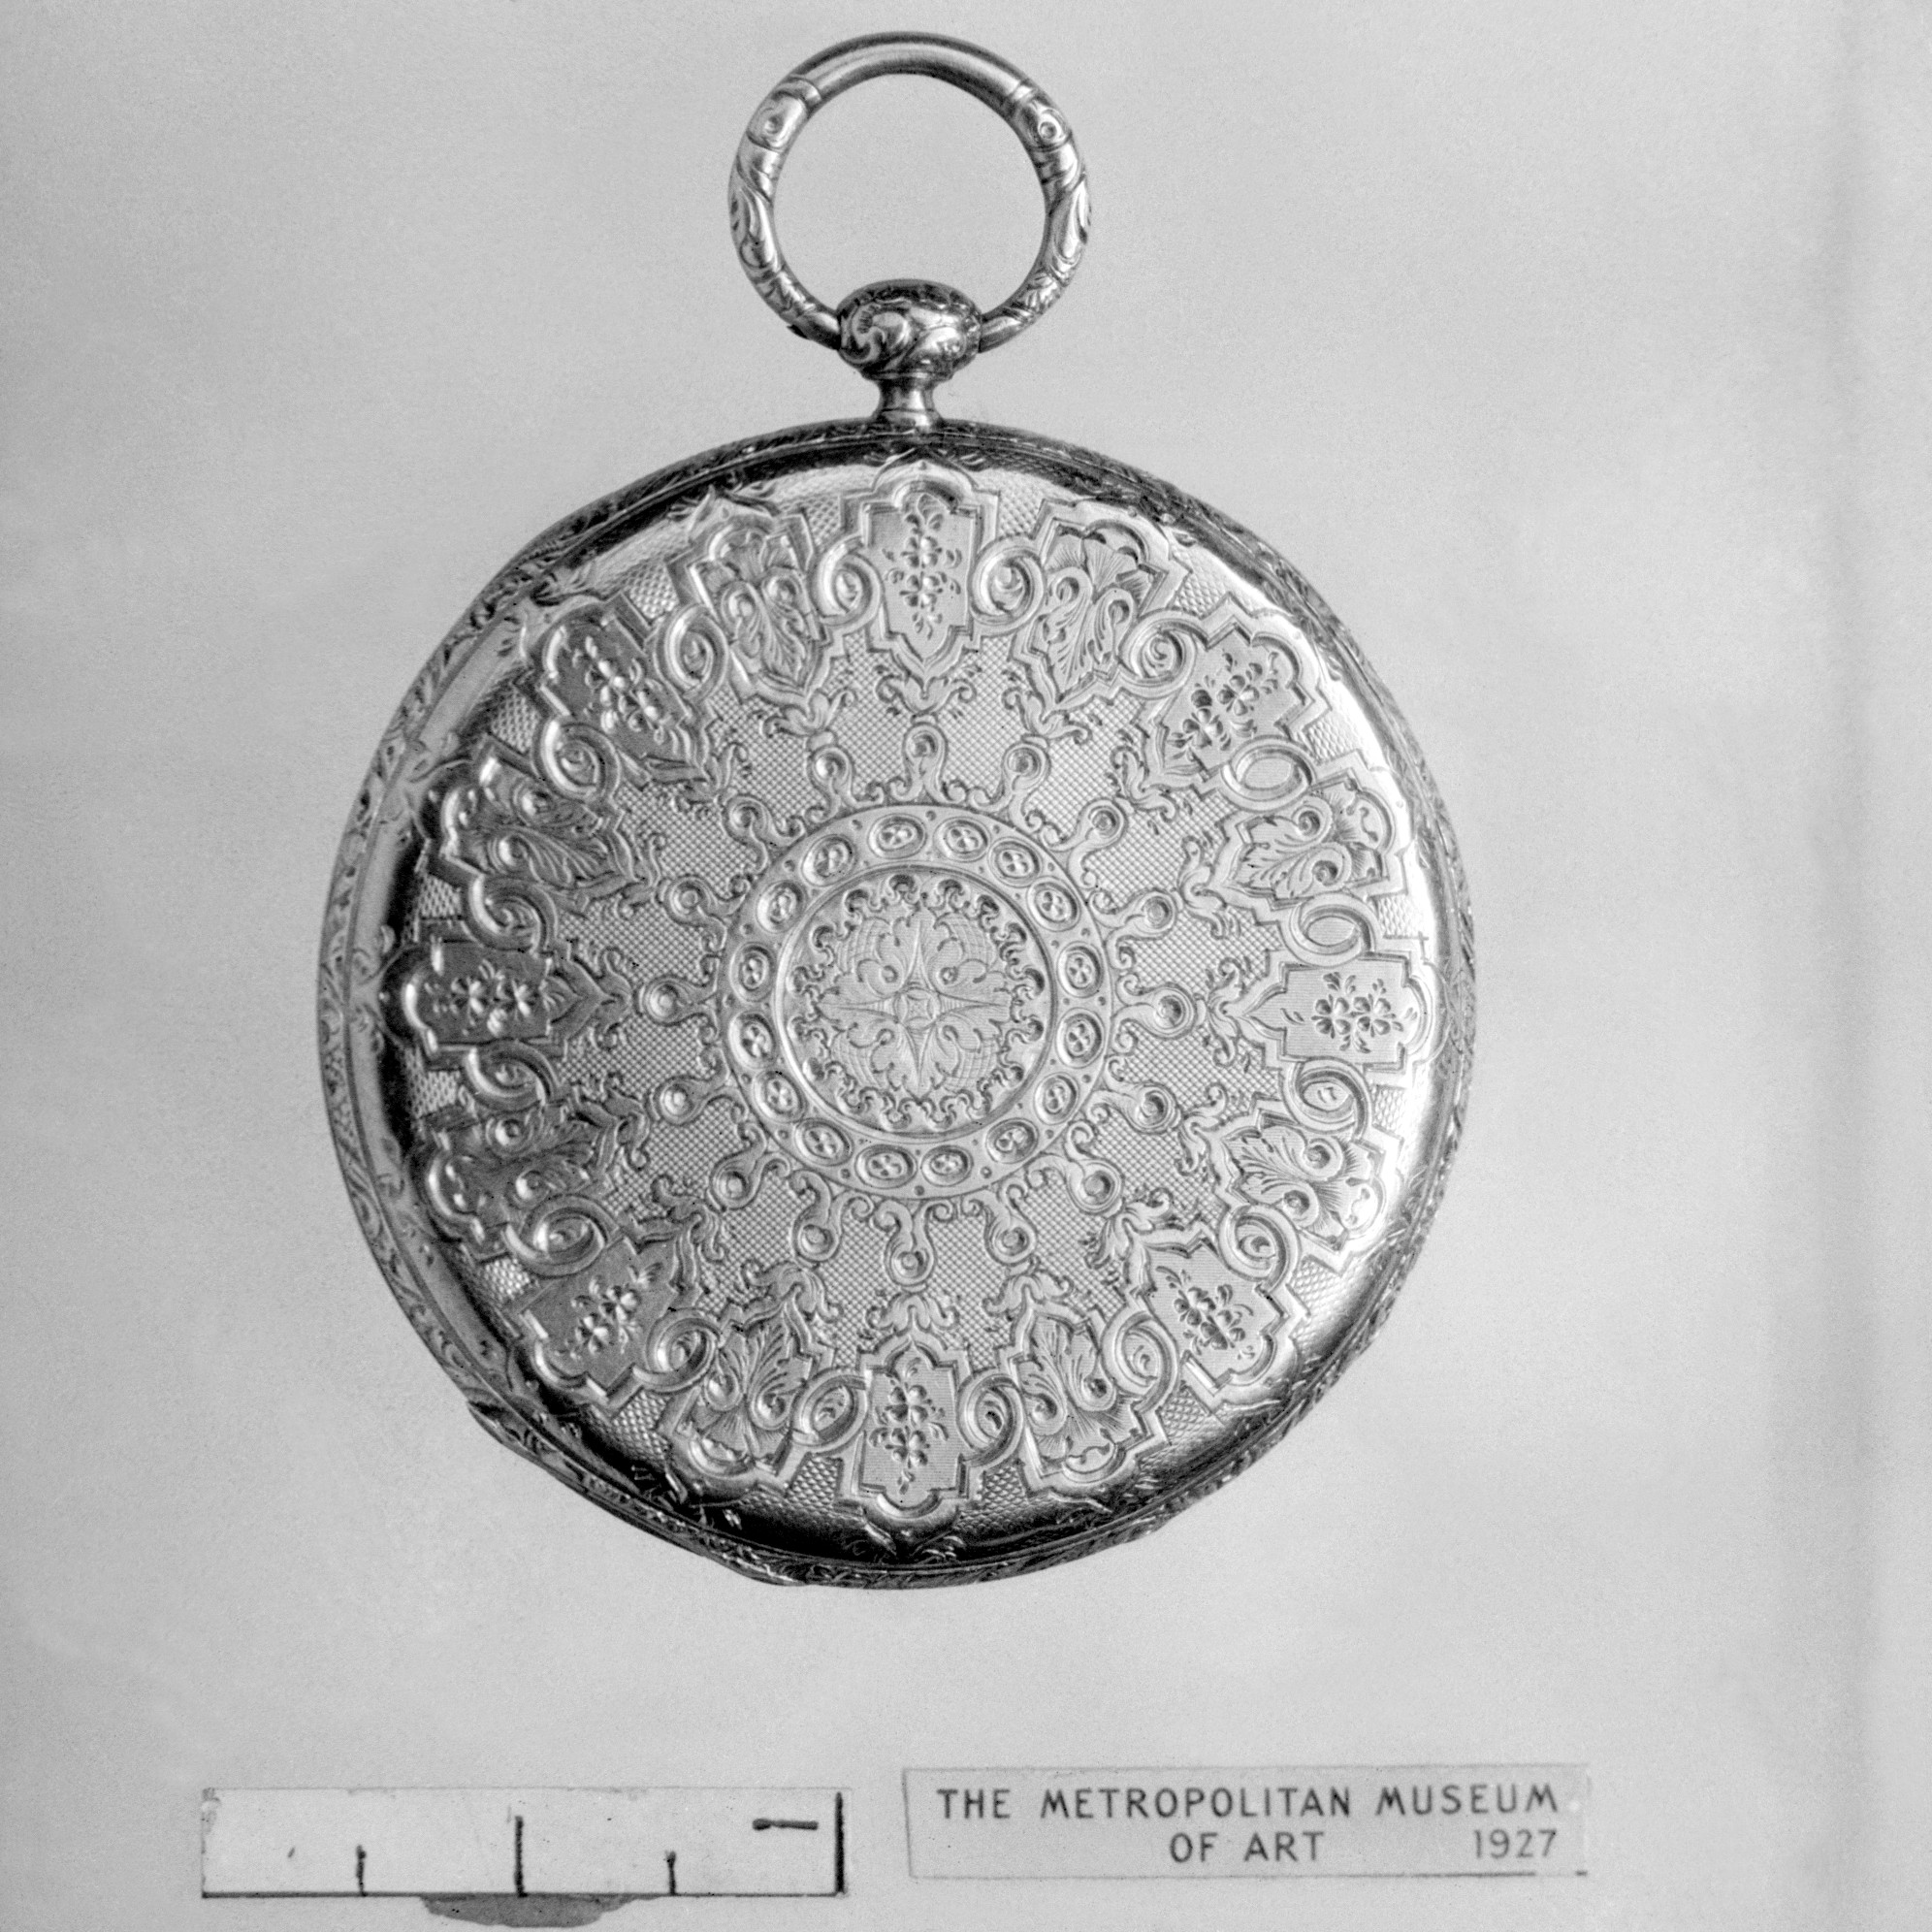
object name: watch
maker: frederick courvoisier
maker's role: maker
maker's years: 1790-1854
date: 1840-1850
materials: enamel, gold